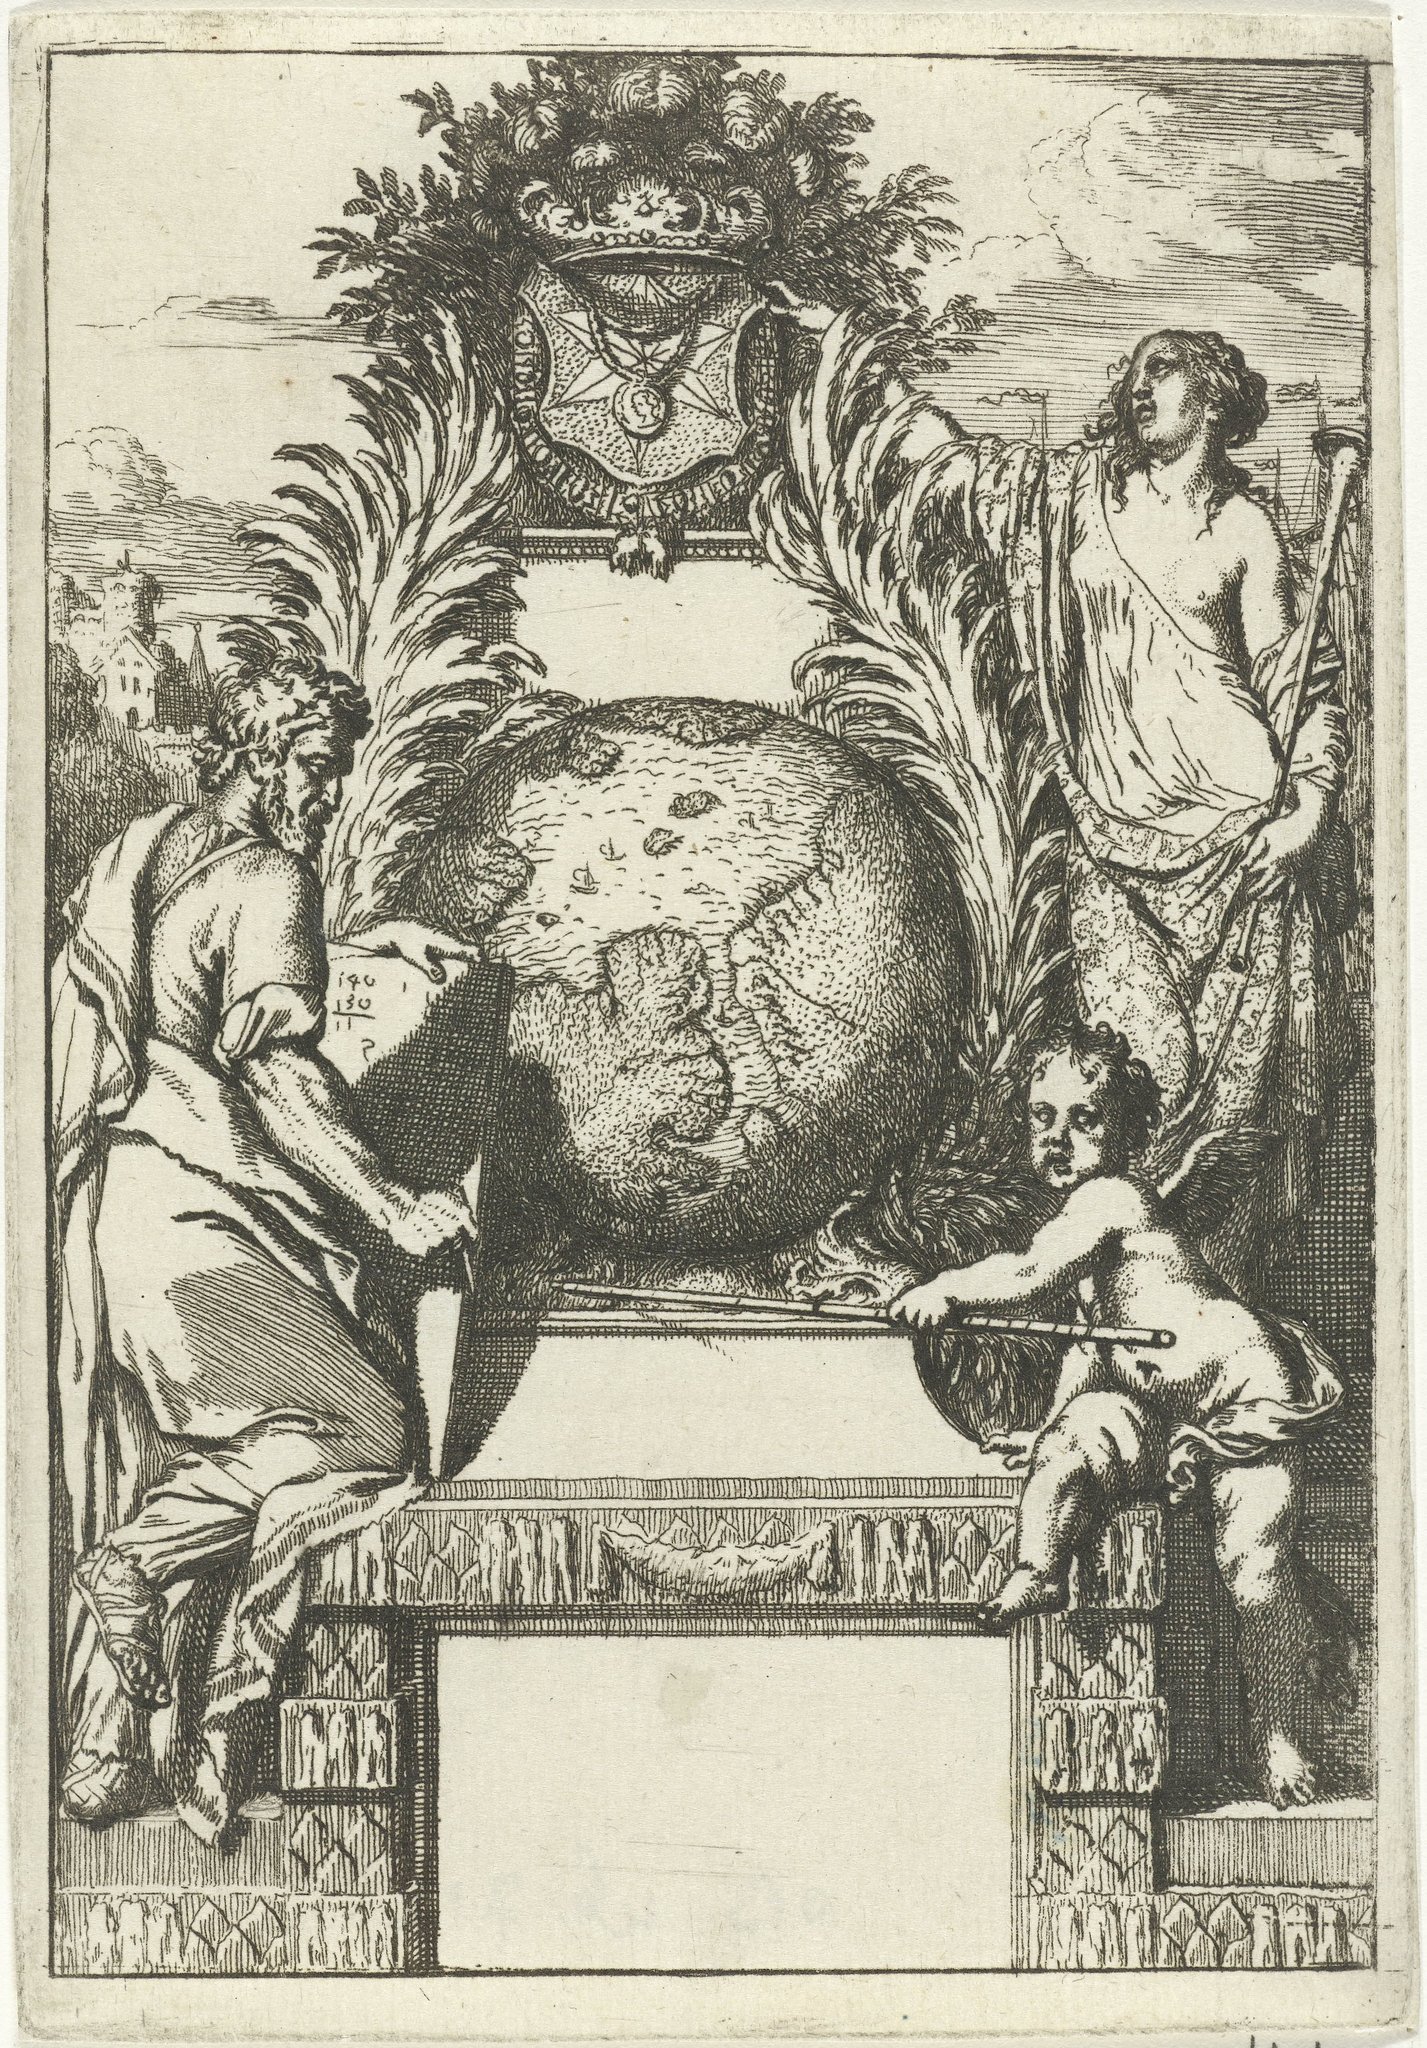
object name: print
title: Globe geflankeerd door allegorische figuren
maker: gerard de lairesse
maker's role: draughtsman, painter, print maker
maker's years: 1641-1711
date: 1670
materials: paper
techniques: etching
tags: writing tablets, horn, trumpet, cornet, trombone, tuba, measuring-instruments, globe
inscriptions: collector's mark: Lugt 2165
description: Een globe rust op een voetstuk en wordt geflankeerd door twee allegorische figuren. De figuur links schrijft cijfers op een tablet, de vrouwfiguur rechts draagt een bazuin en houdt het gekroonde wapen boven de globe vast. Rechts naast het voetsuk zit een putto met een meetstok.